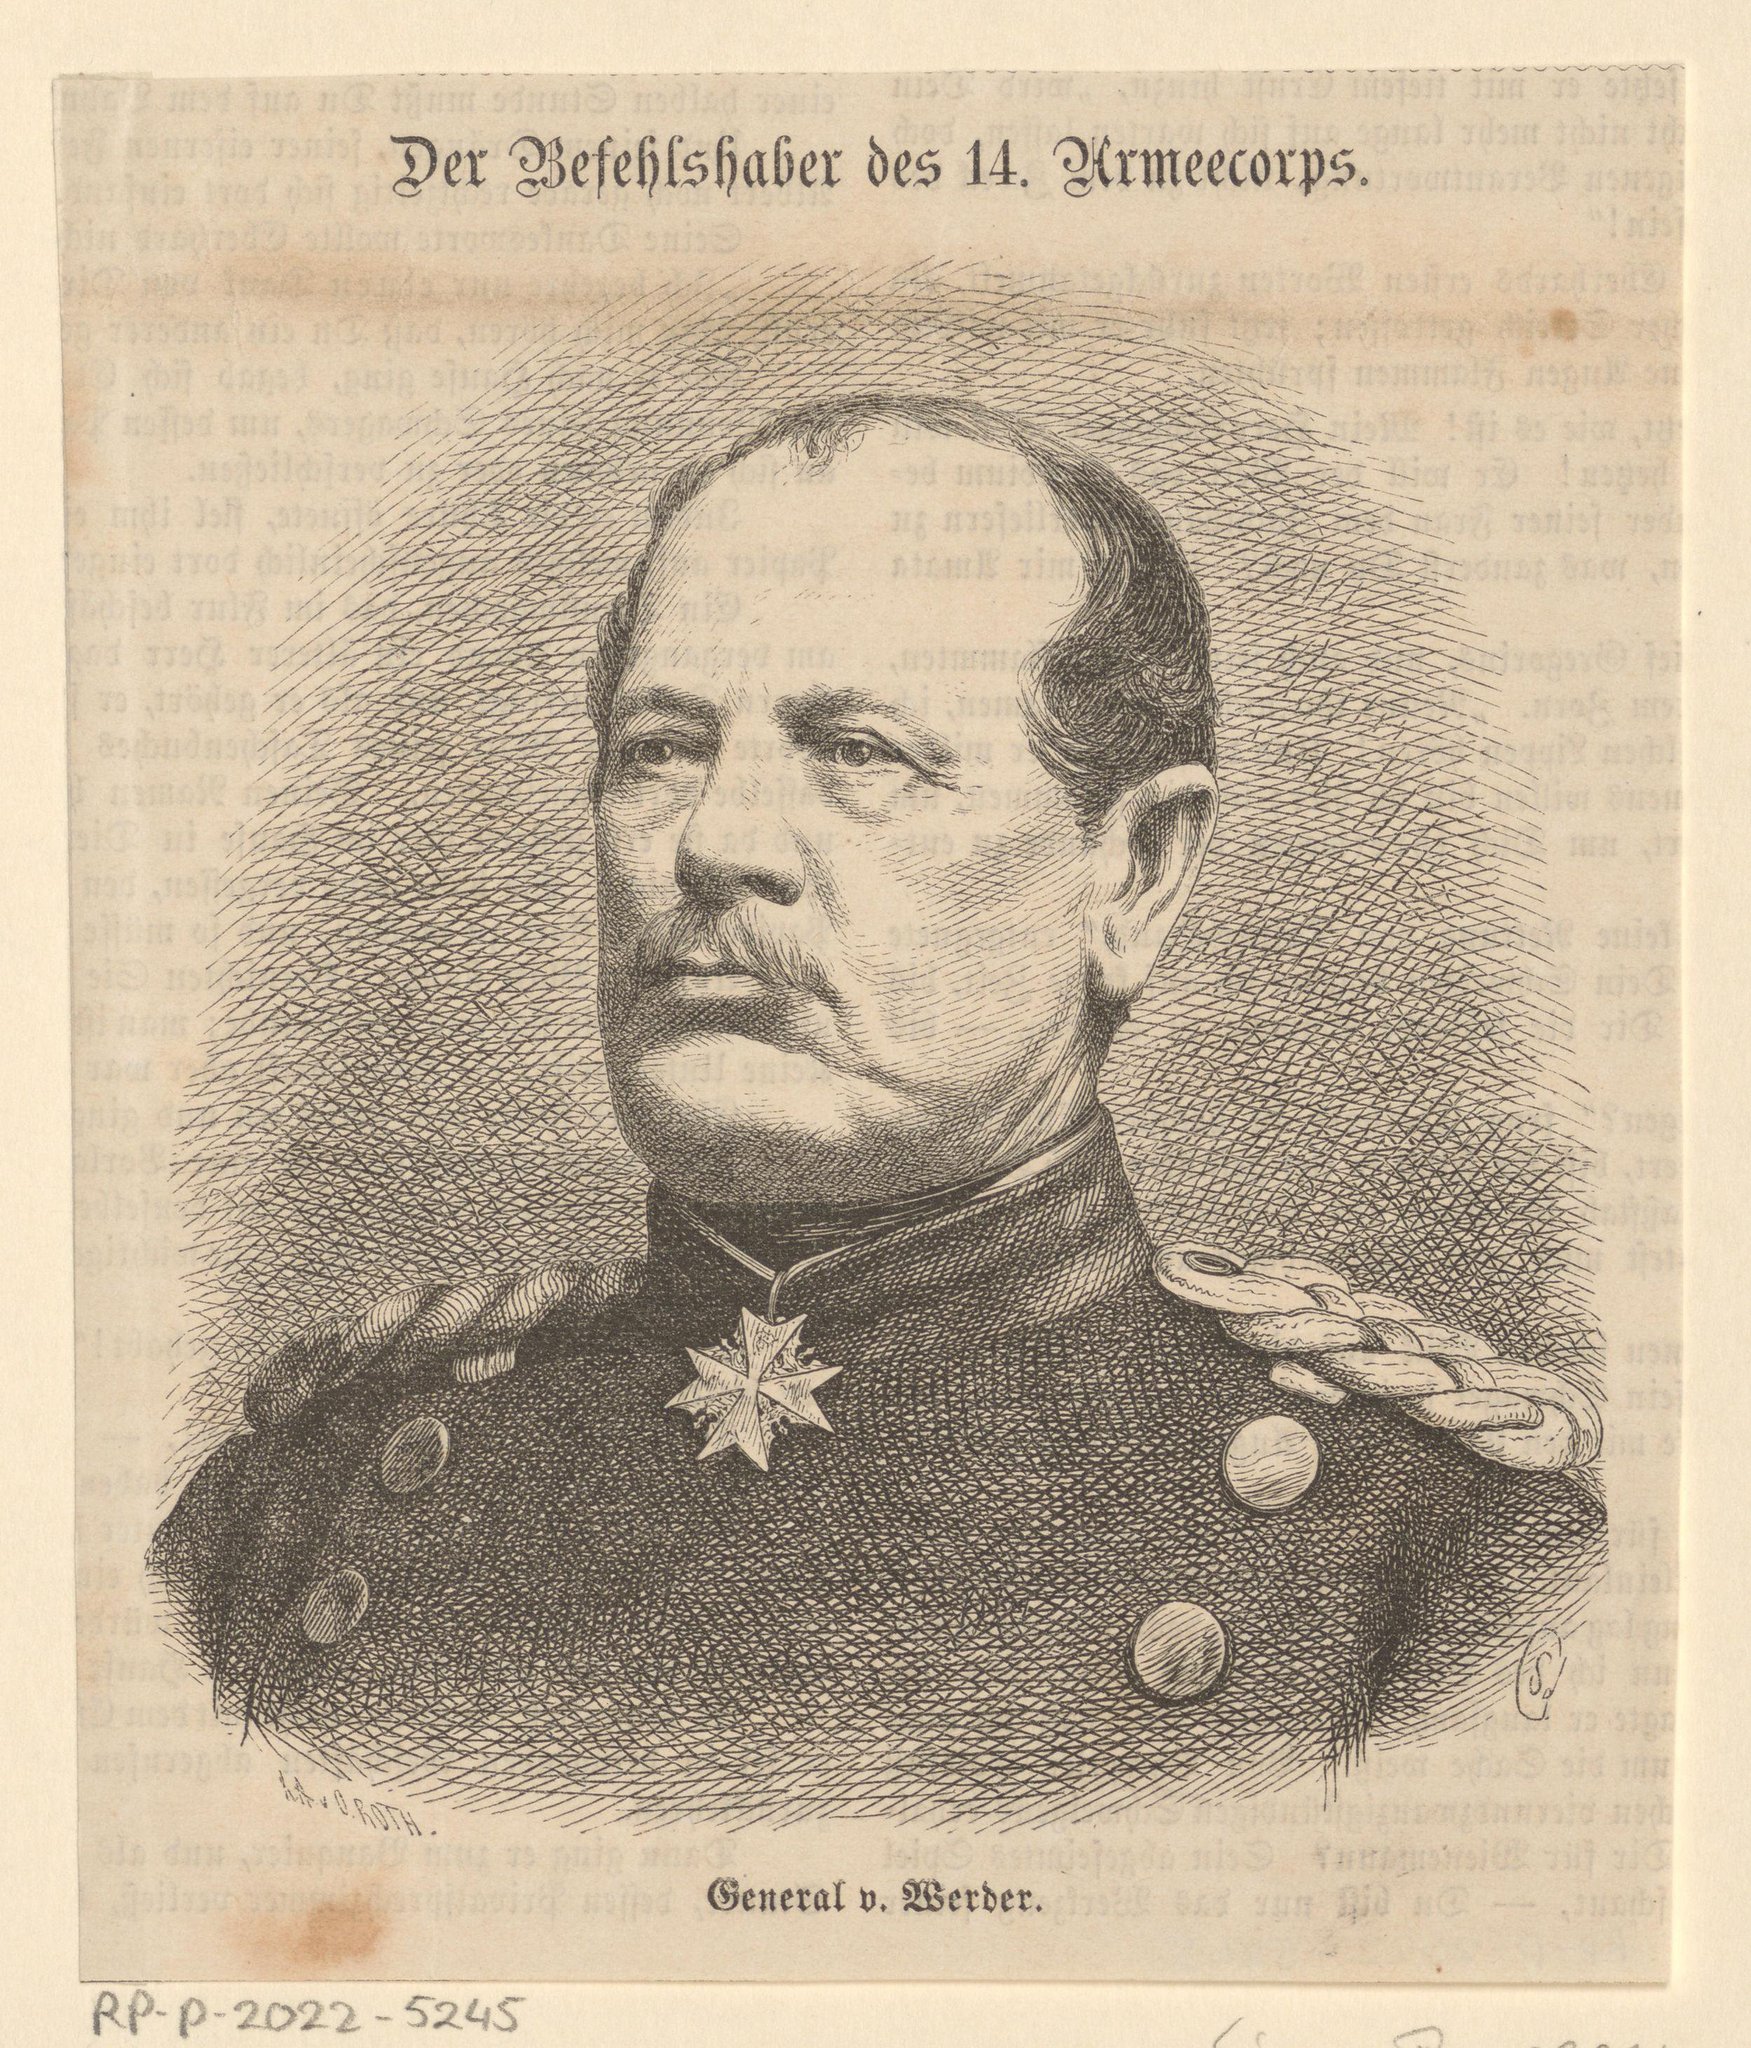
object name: print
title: Portret van August von Werder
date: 1811-1870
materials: paper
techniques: letterpress printing, engraving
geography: bielefeld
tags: commander-in-chief, general, marshal, historical persons, medals and other marks of military honour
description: Prent uit: Daheim, nr. 8 (jaargang 1871), november 1870.